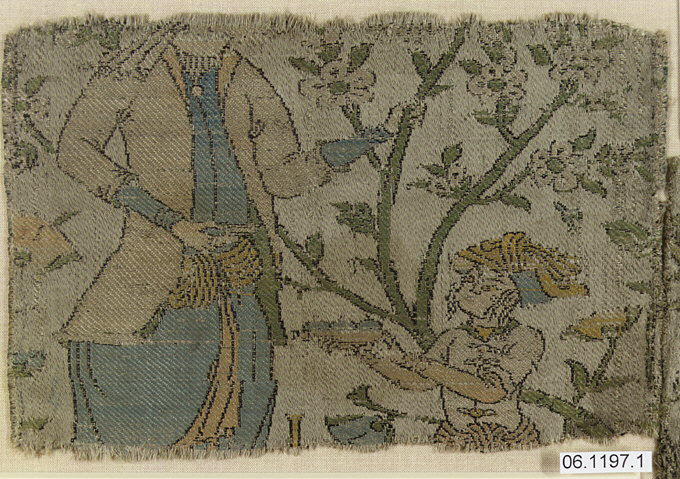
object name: textile fragment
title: Textile Fragment Depicting Figures in a Landscape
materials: metal thread, silk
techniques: lampas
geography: iran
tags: human figures,leaves